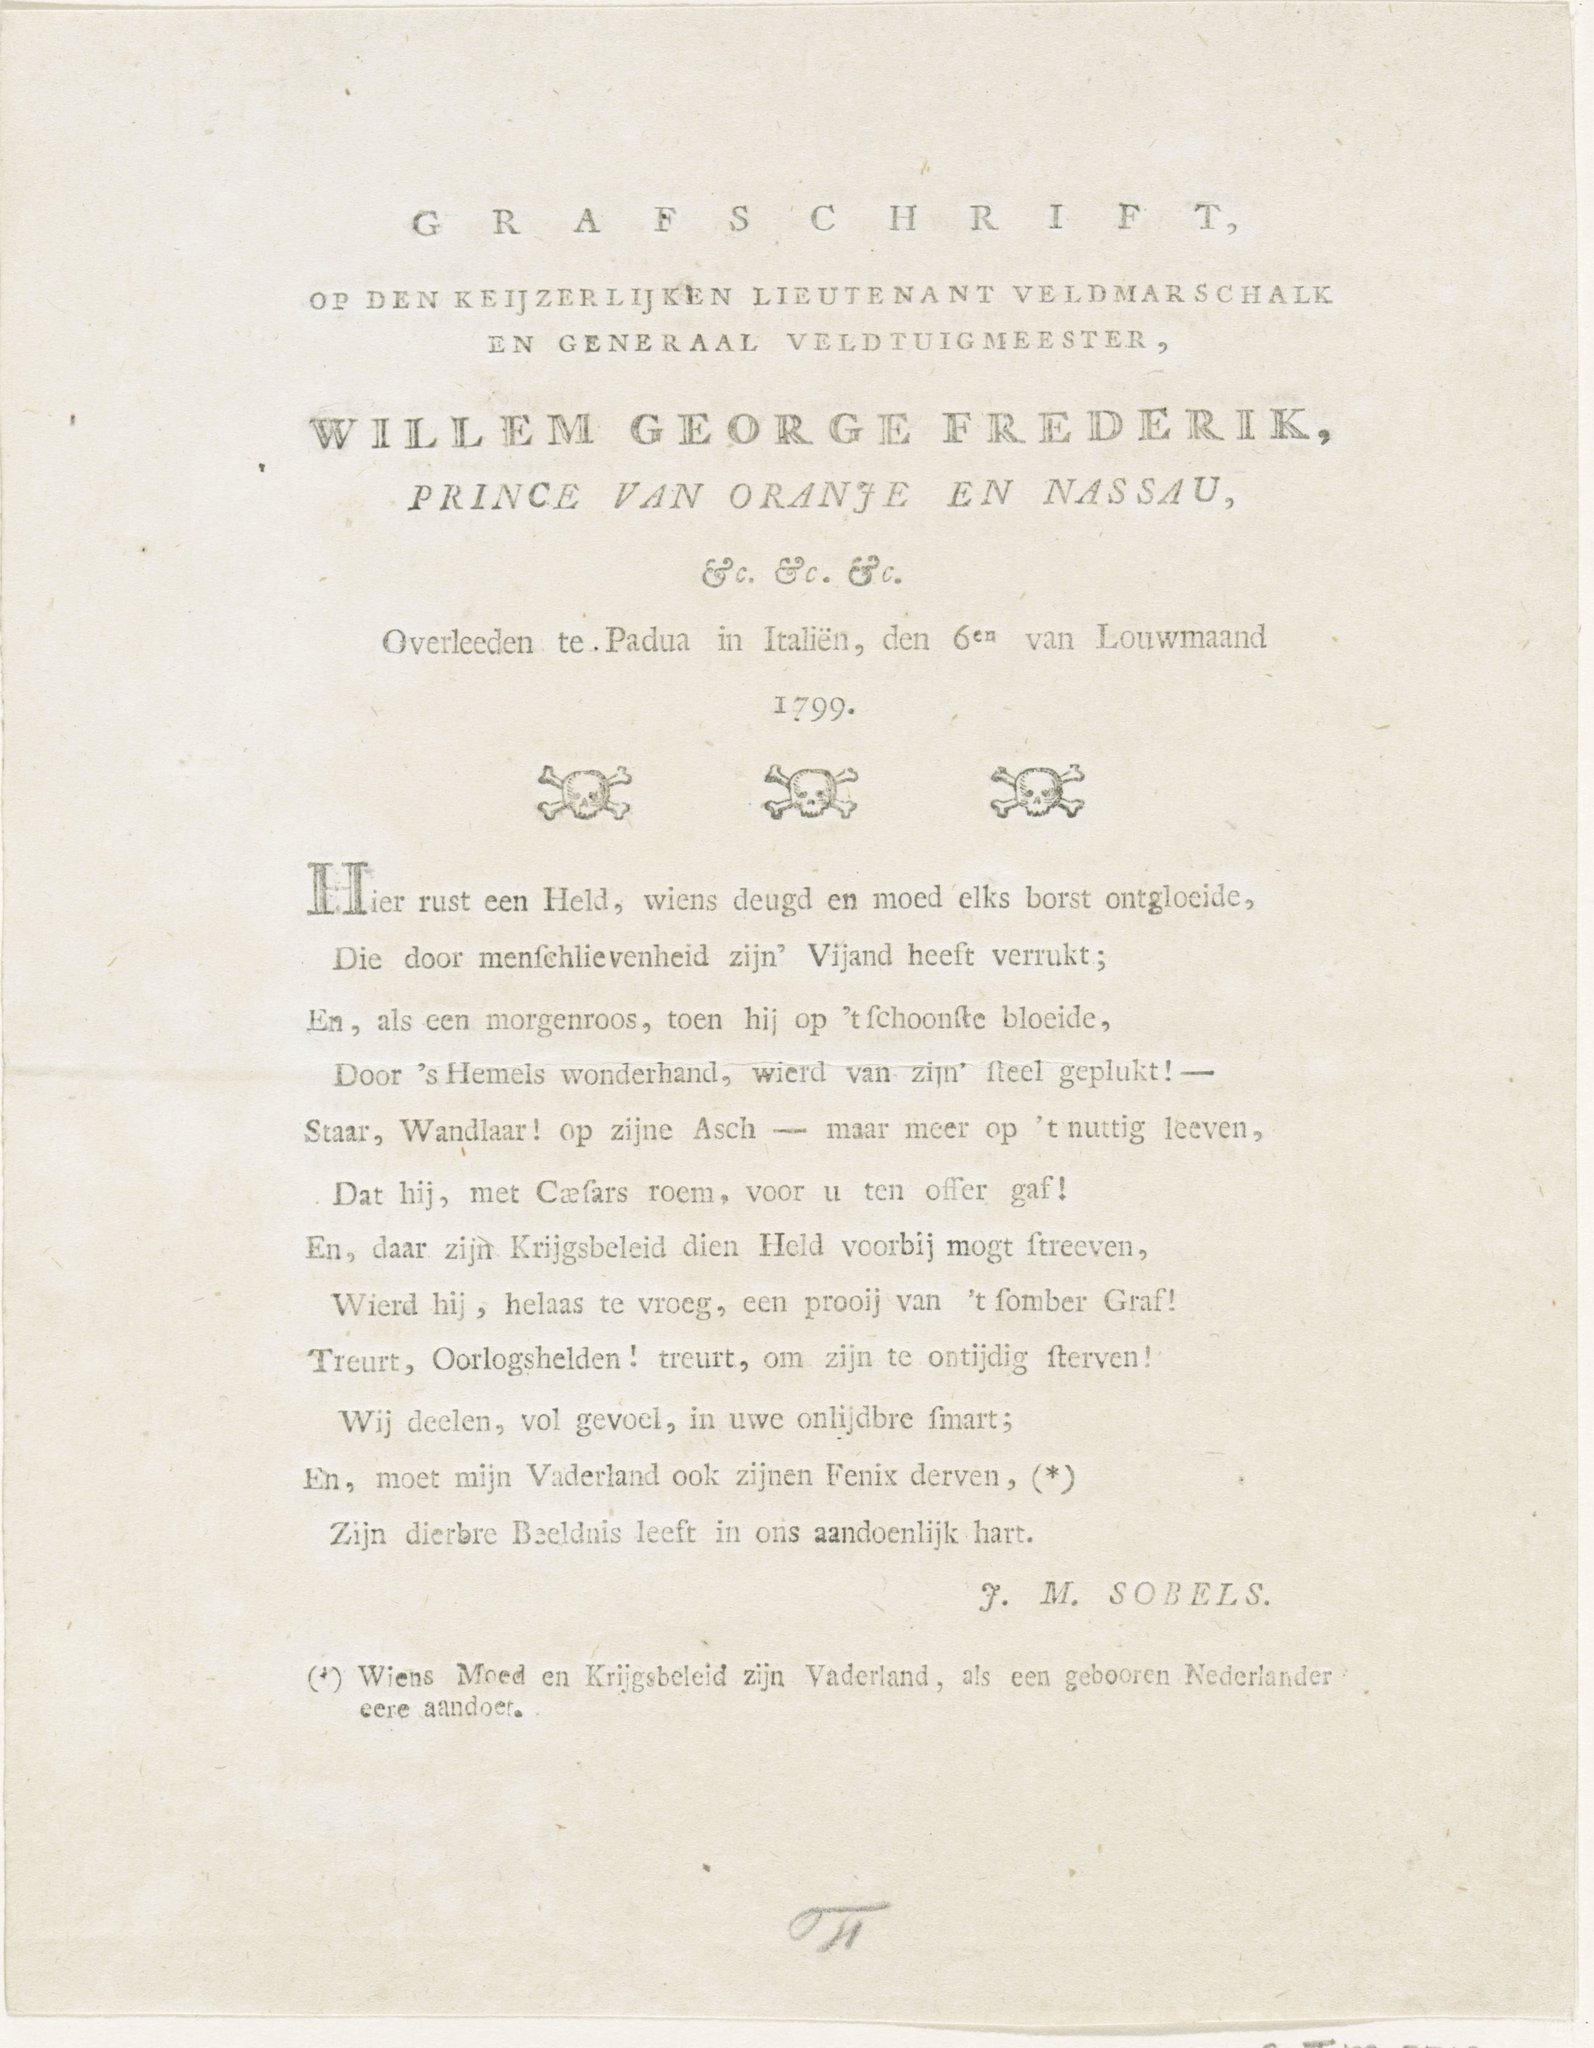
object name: text sheet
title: Grafschrift voor prins Frederik, 1799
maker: johannes mattheus sobels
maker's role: schrijver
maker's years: 1784-1820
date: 1799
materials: paper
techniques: letterpress printing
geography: netherlands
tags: the hague, willem george frederik (prins van oranje-nassau)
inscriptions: collector's mark: Lugt 2228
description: Tekstblad met grafschrift van twaalf regels voor Willem George Frederik, prins van Oranje-Nassau, overleden te Padua, 6 januari 1799.